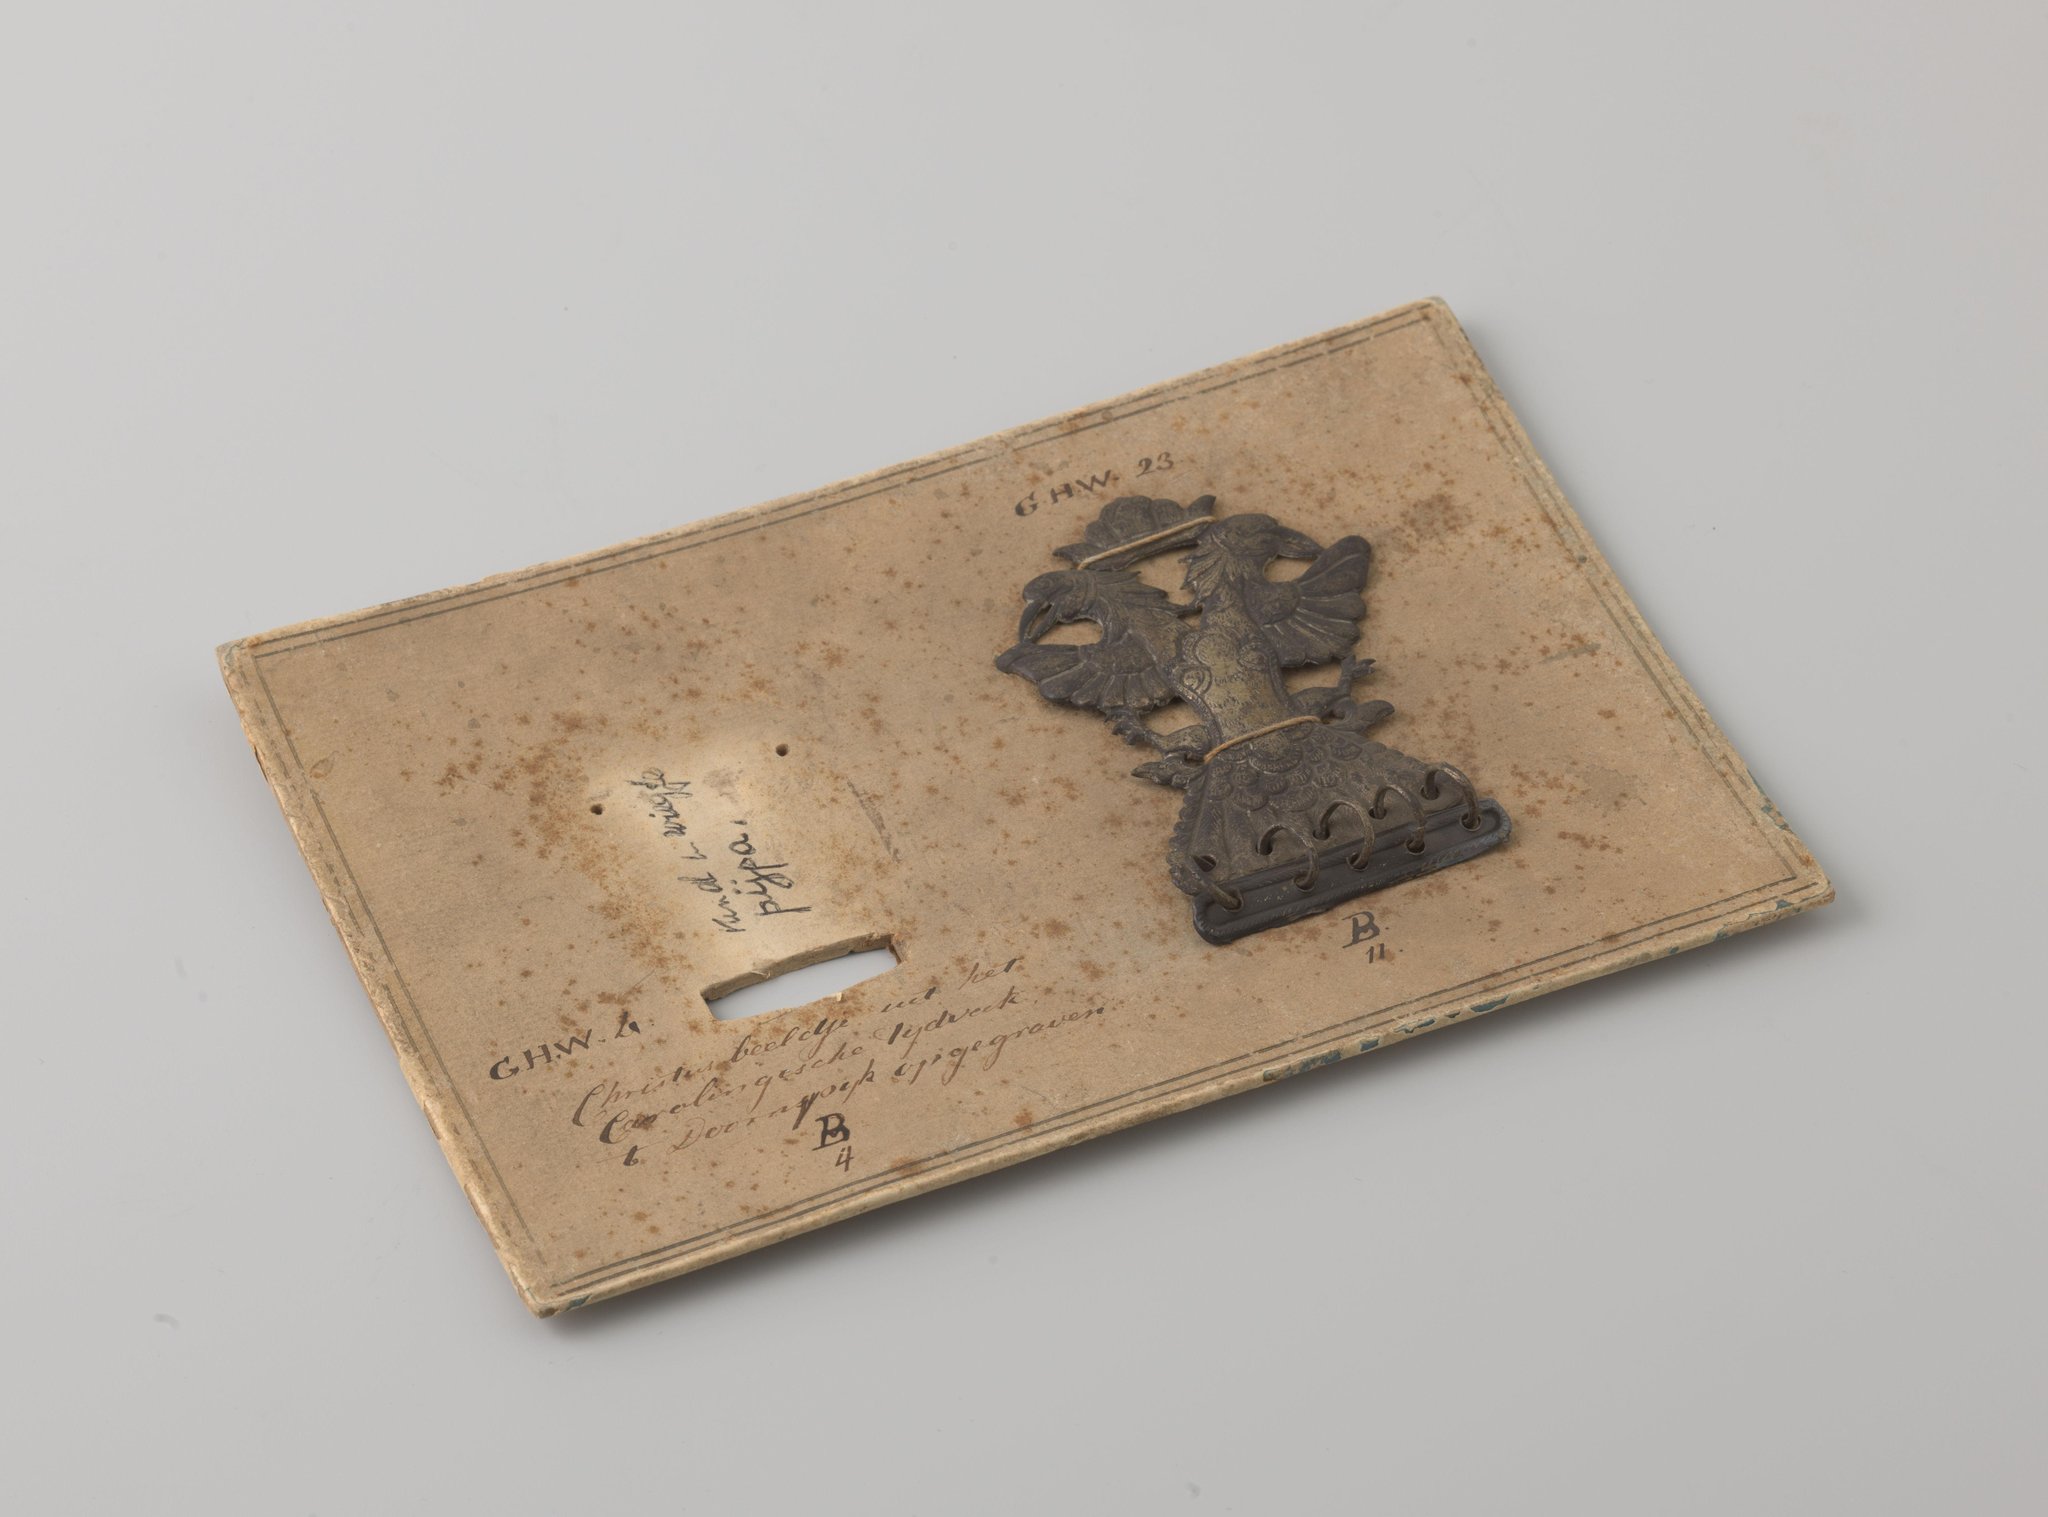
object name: insignia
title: Insigne met dubbele adelaar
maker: Anonymous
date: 1400-1950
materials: silver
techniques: repoussé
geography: netherlands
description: Insigne met dubbele adelaar van gedreven zilver.